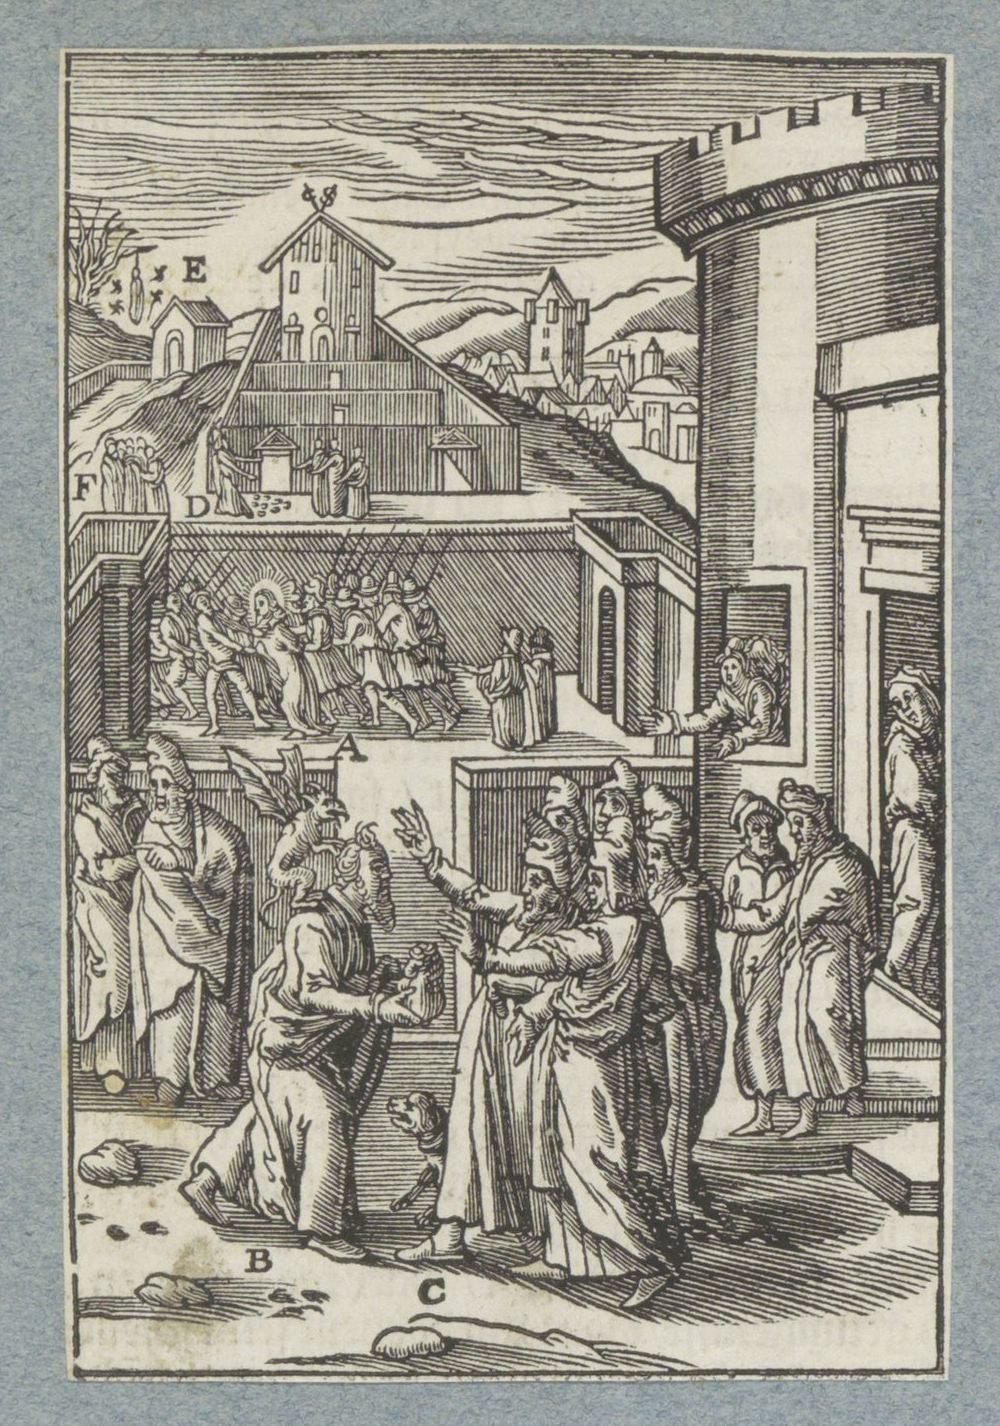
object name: book illustration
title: Berouw van Judas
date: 1629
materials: paper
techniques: letterpress printing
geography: amsterdam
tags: christ brought from one judge to another, judas before the sanhedrin returning the pieces of silver; he throws the money to the ground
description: Judas, met duivel, krijgt berouw nadat hij ziet dat Christus ter dood veroordeeld is. Hij brengt de dertig zilverstukken naar de hogepriesters en oudsten terug. Zij sturen hem echter weer weg. Daarachter is te zien hoe Christus ’s ochtends overgeleverd wordt aan Pilatus. Achteraan smijt Judas de zilverstukken op de grond en hangt zichzelf op. Bij verschillende elementen uit de voorstelling staan letters. De prent maakt deel uit van een album.